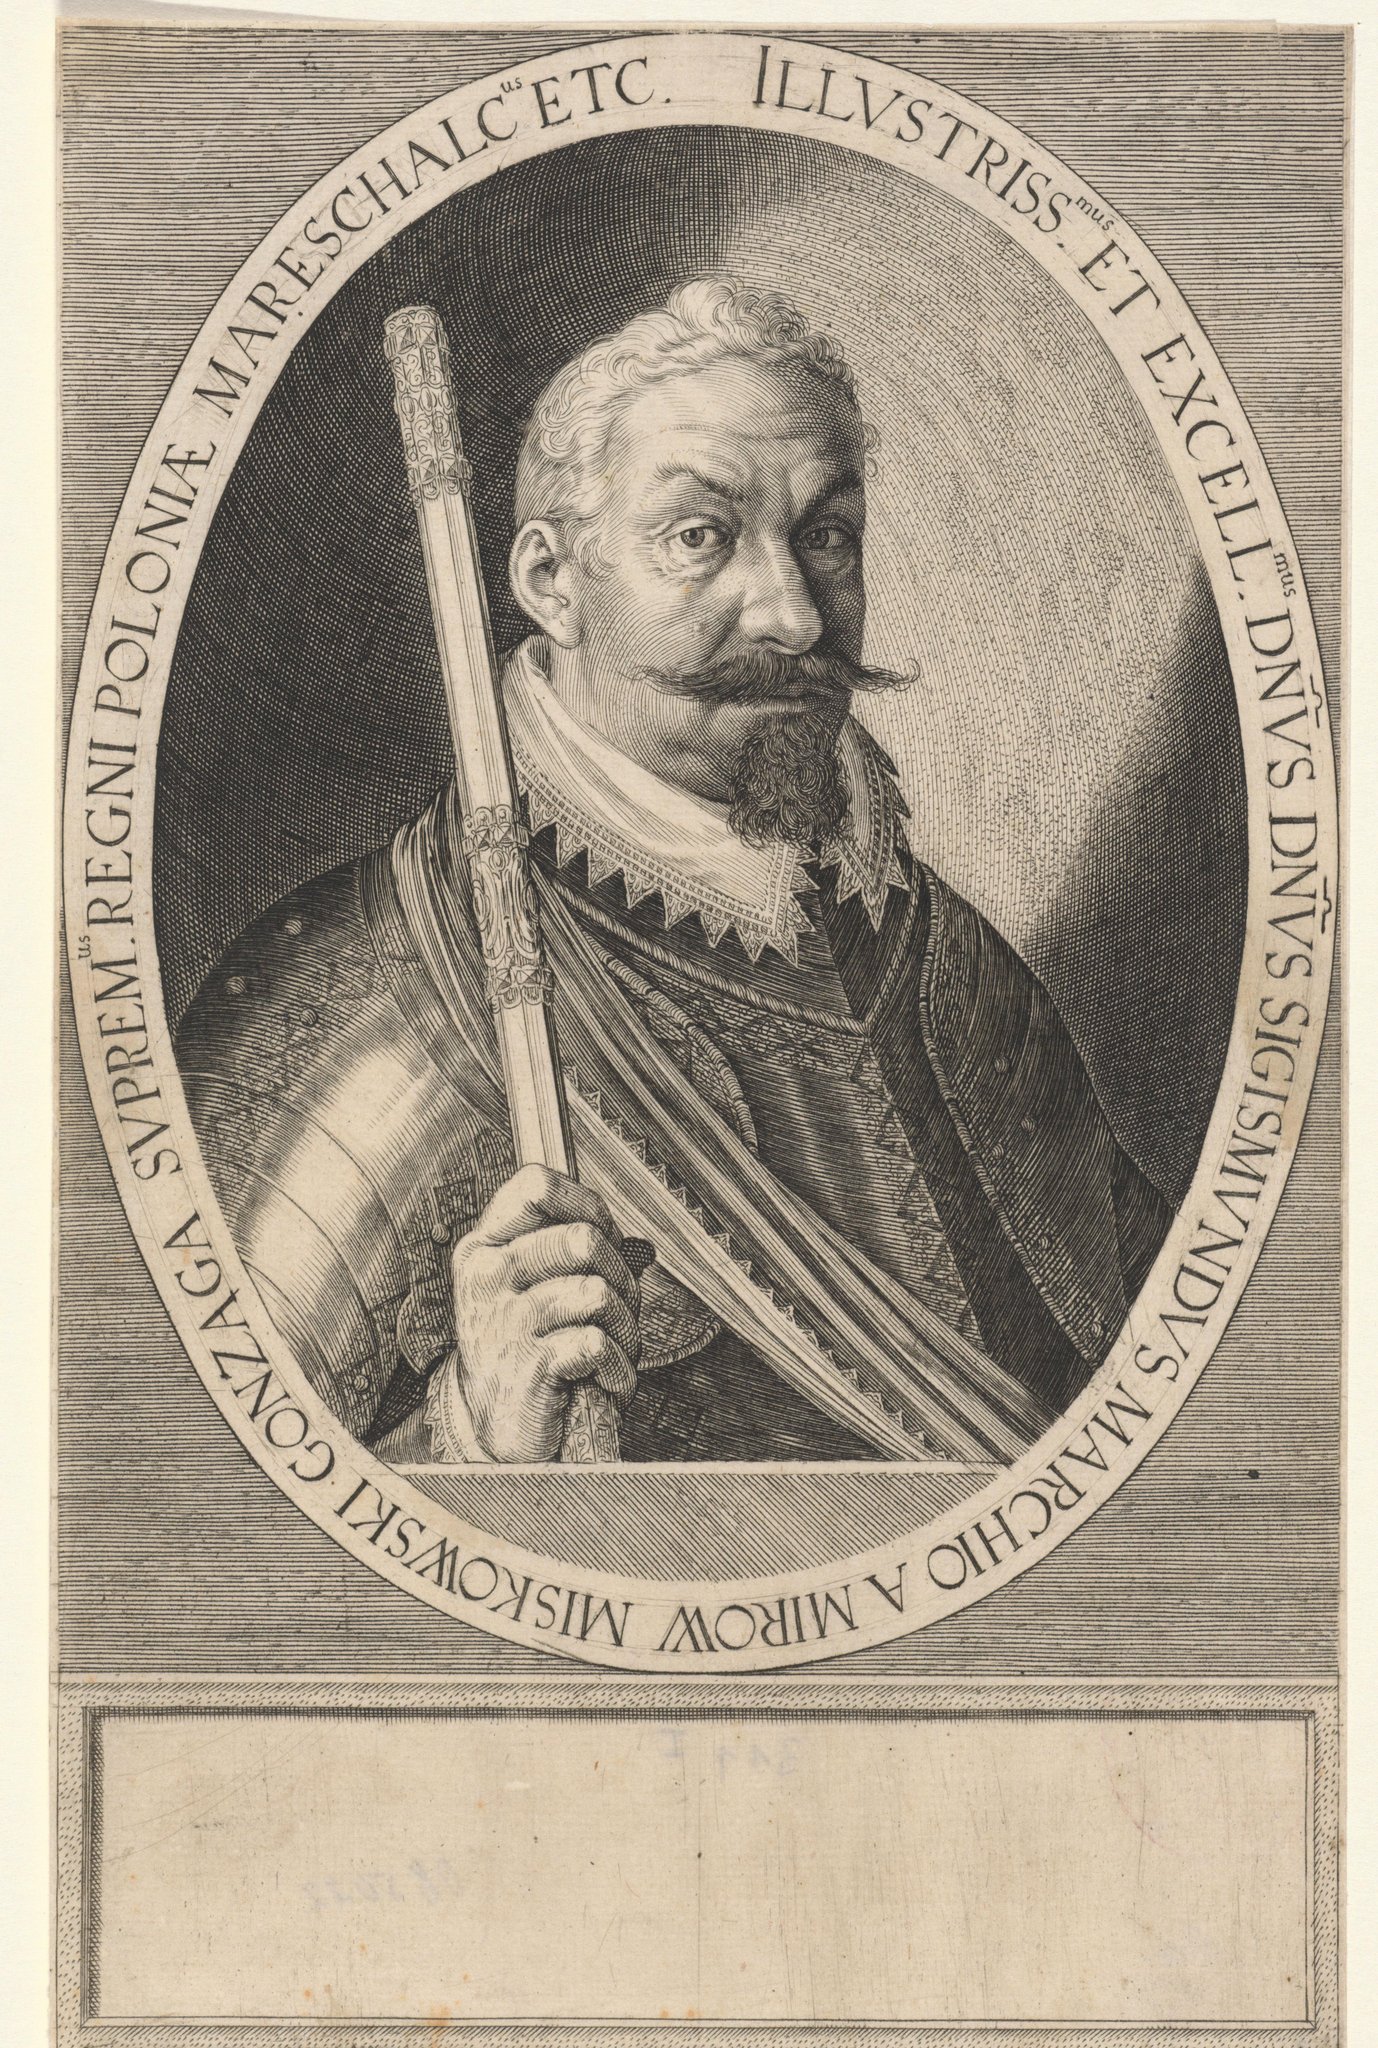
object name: print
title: Portret van Sigismund Gonzaga Myszkowski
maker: aegidius sadeler (ii)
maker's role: draughtsman, print maker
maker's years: 1568-1629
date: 1580-1629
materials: paper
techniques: engraving, etching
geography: prague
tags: sigismund gonzaga myszkowski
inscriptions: collector's mark: Lugt 240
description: Sigismund Gonzaga Myszkowski, Poolse maarschalk. Met opgeheven maarschalkstaf in de rechterhand.